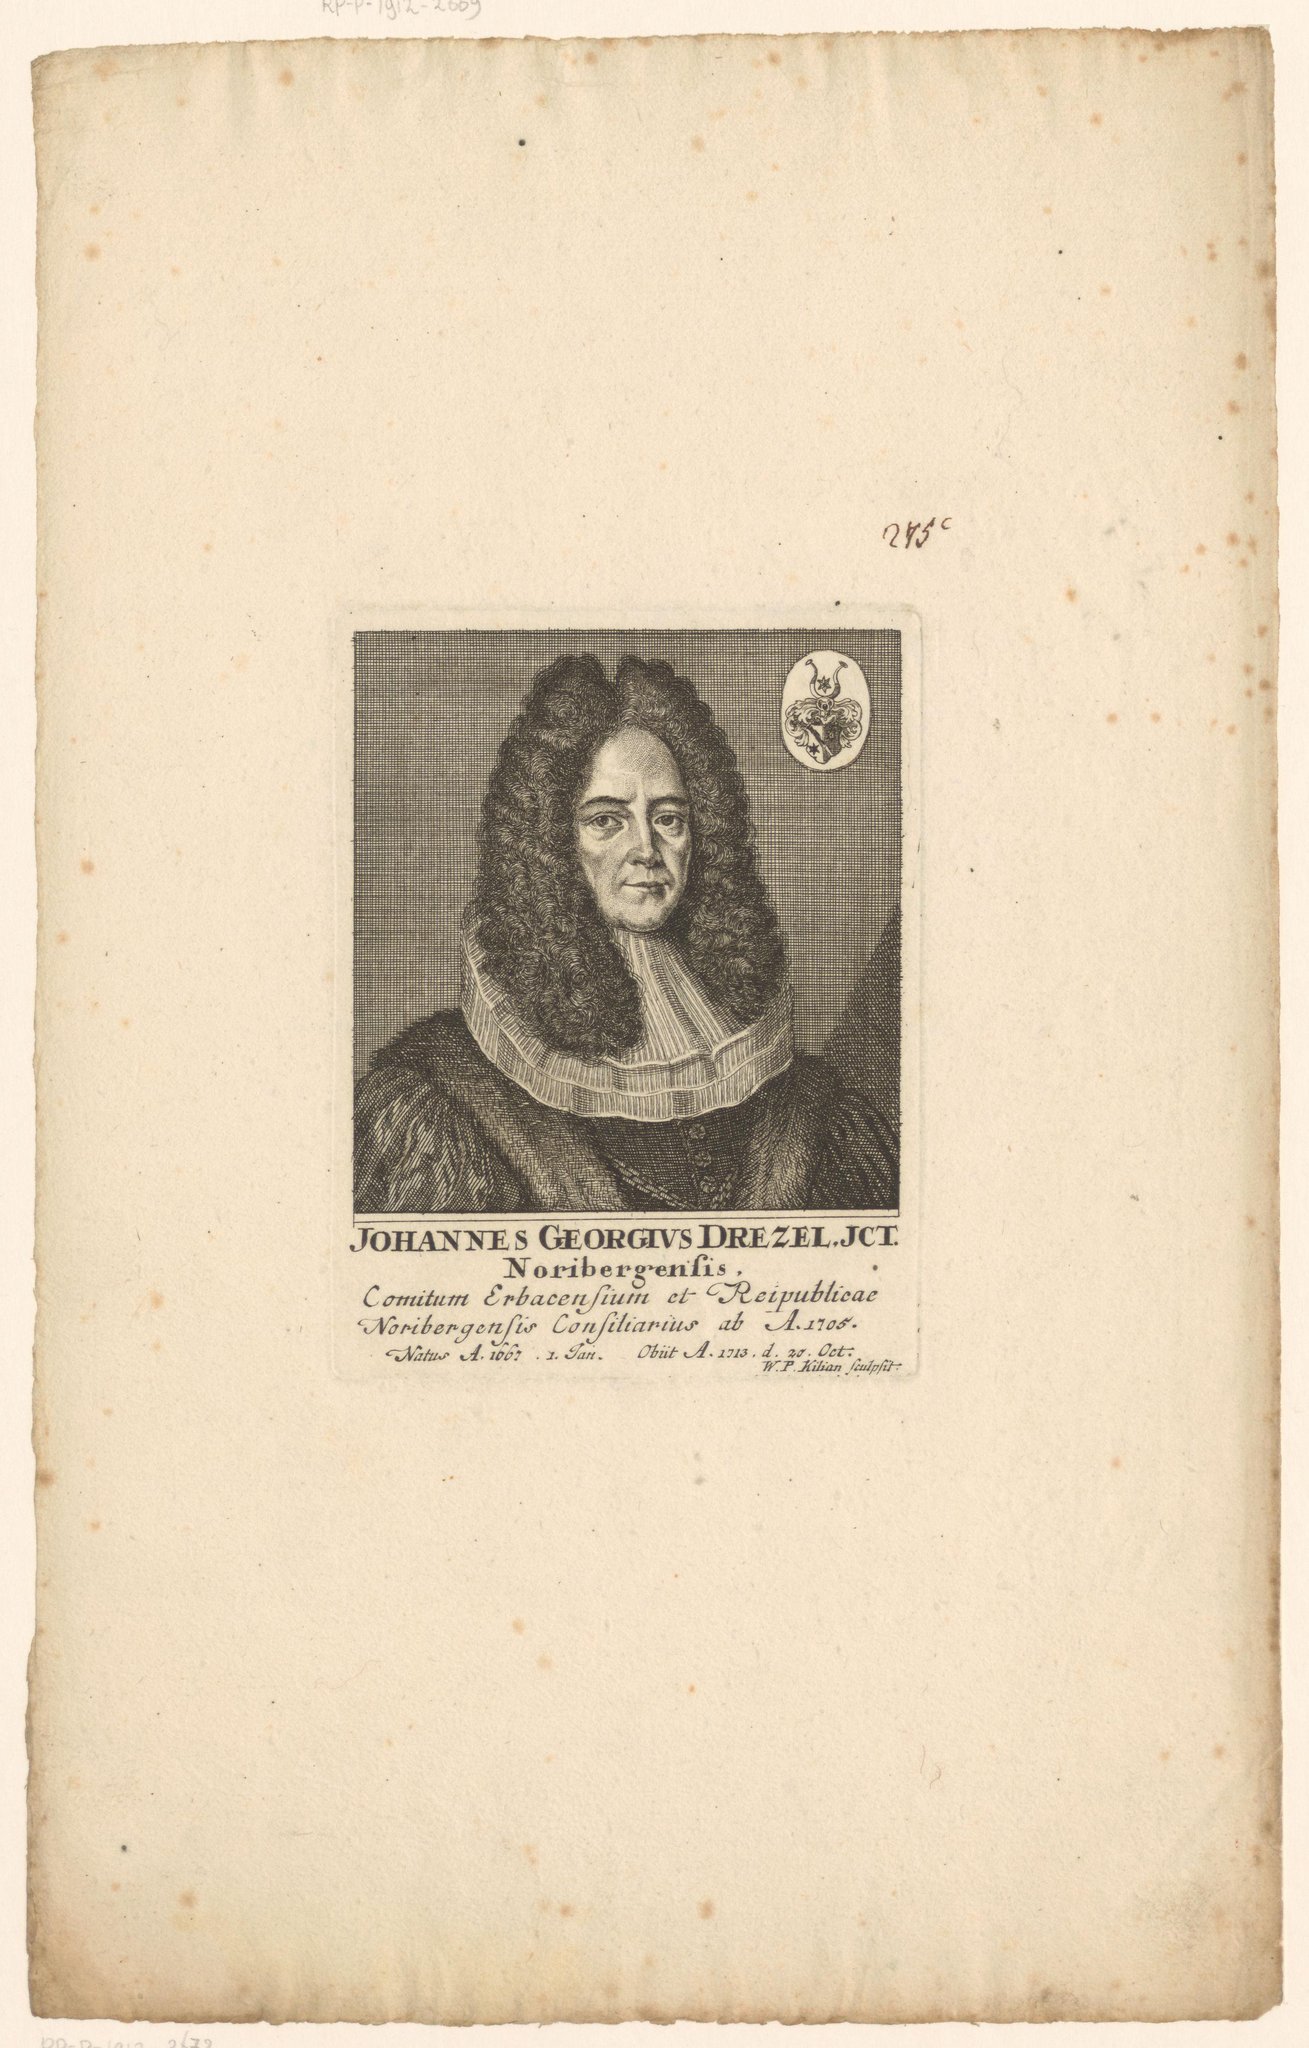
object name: print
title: Portret van Johann Georg Drezel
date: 1713-1732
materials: paper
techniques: engraving, etching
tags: historical persons, lawyer, attorney at law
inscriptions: collector's mark: Lugt 2228